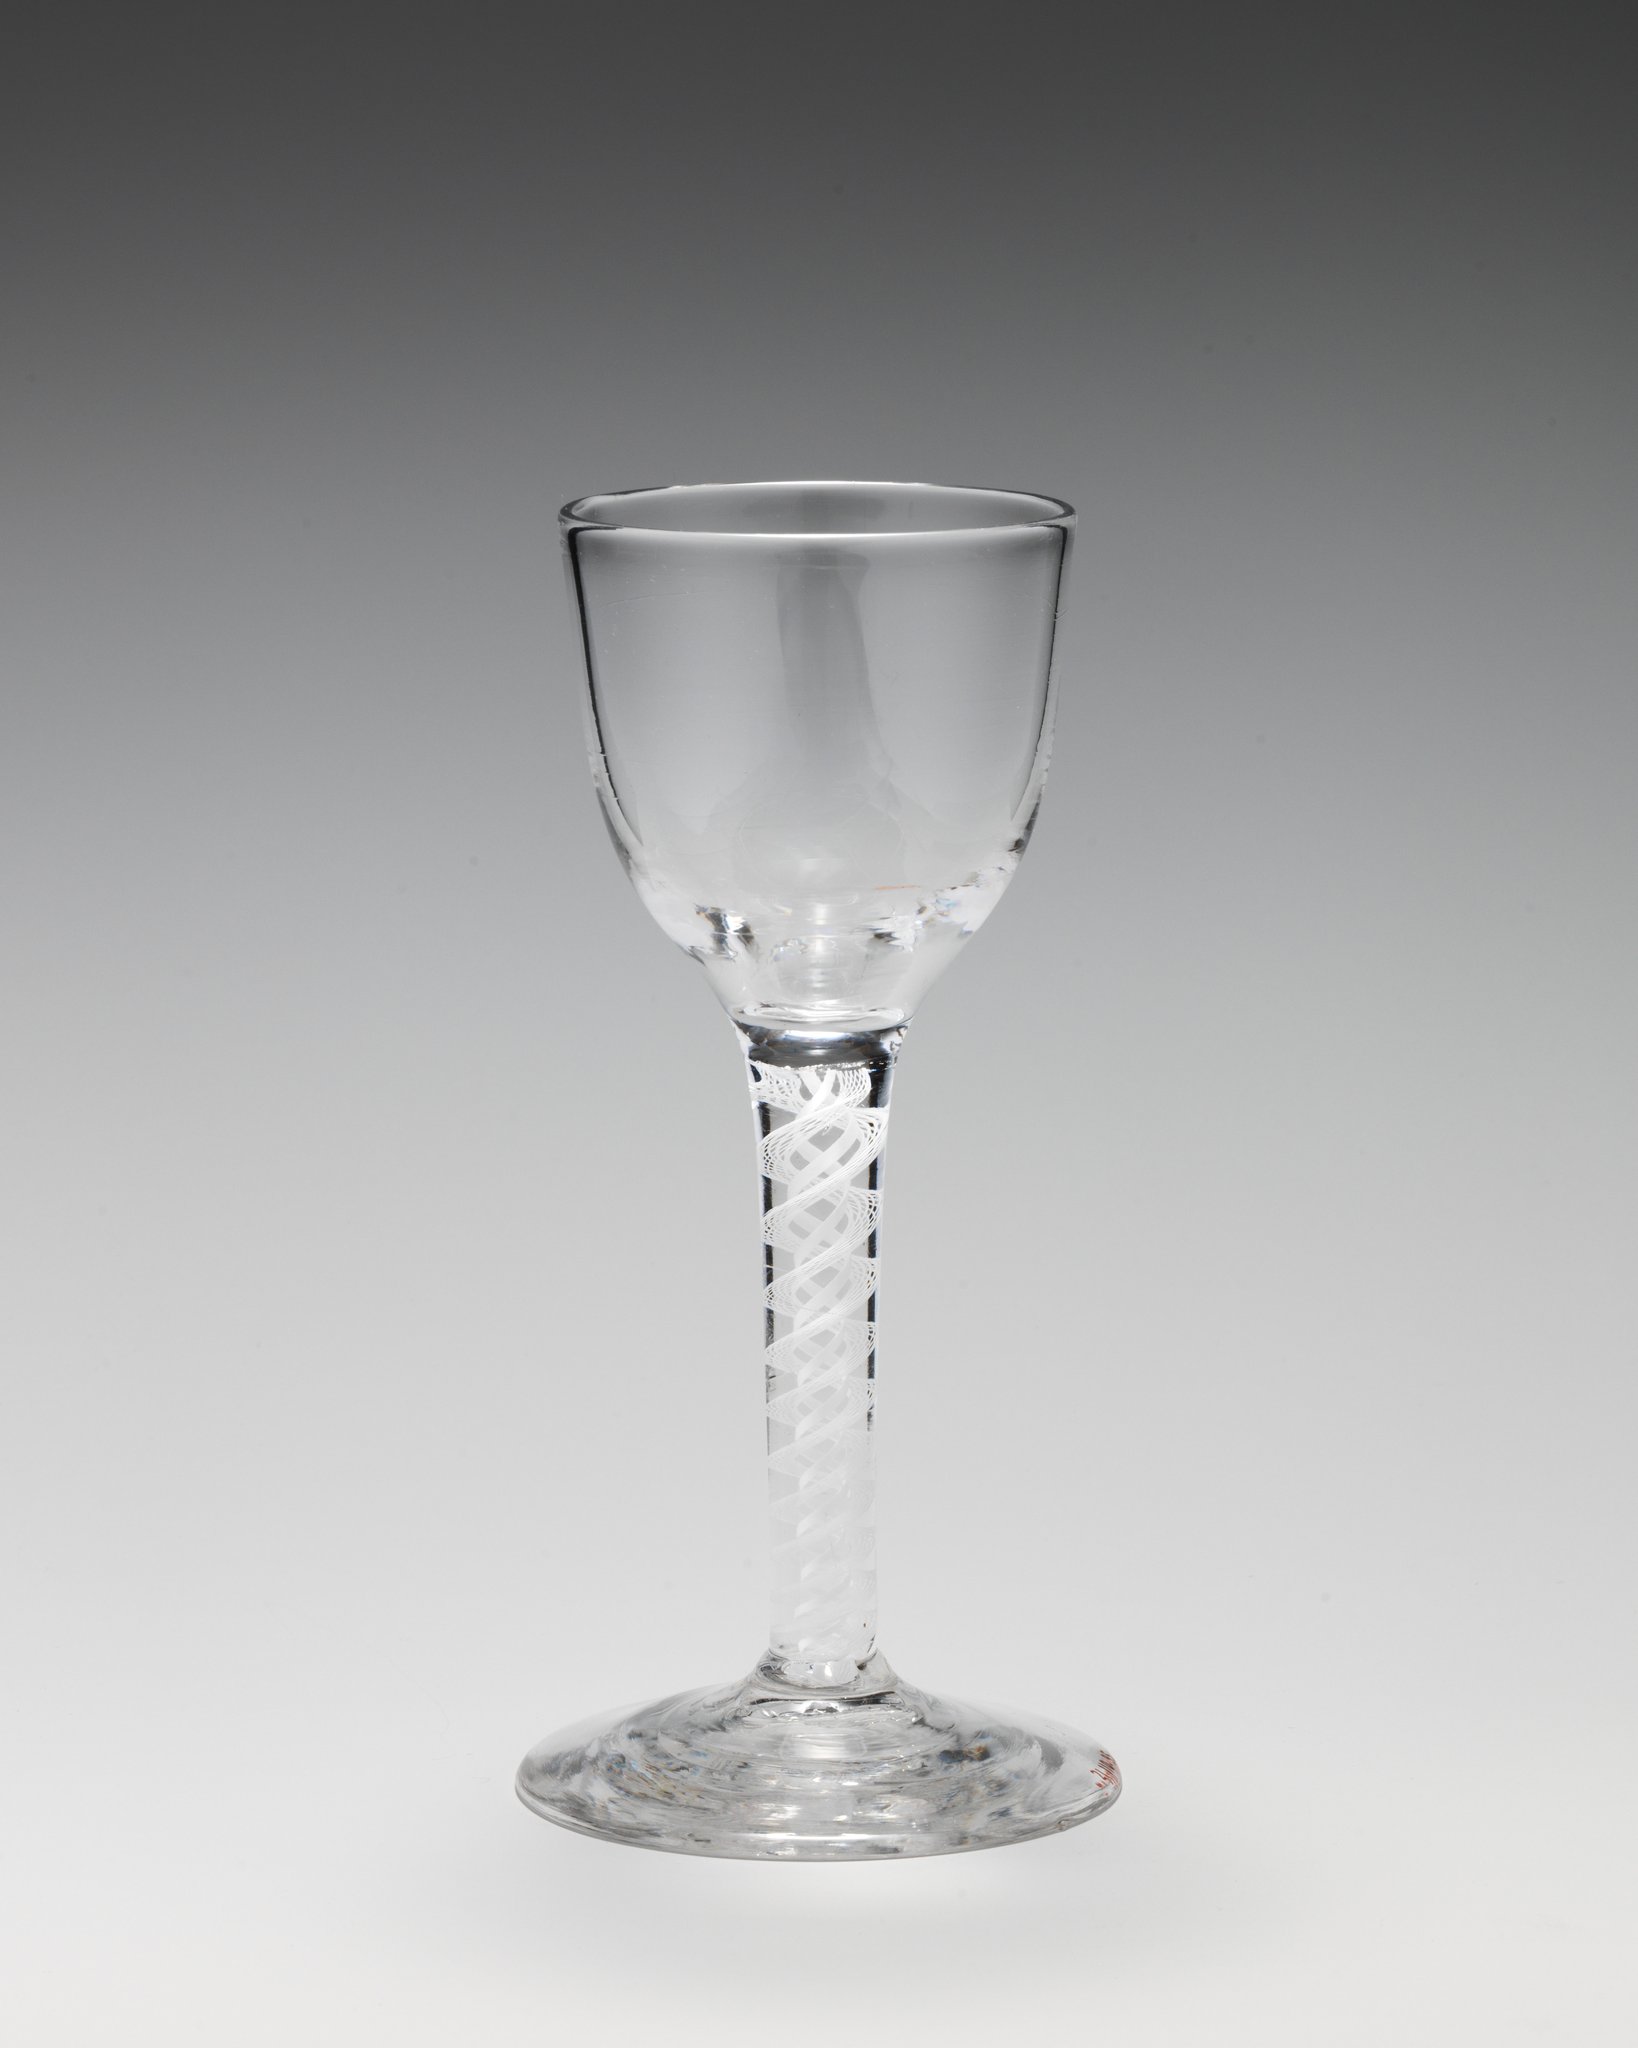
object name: wineglass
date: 1750-1800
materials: glass